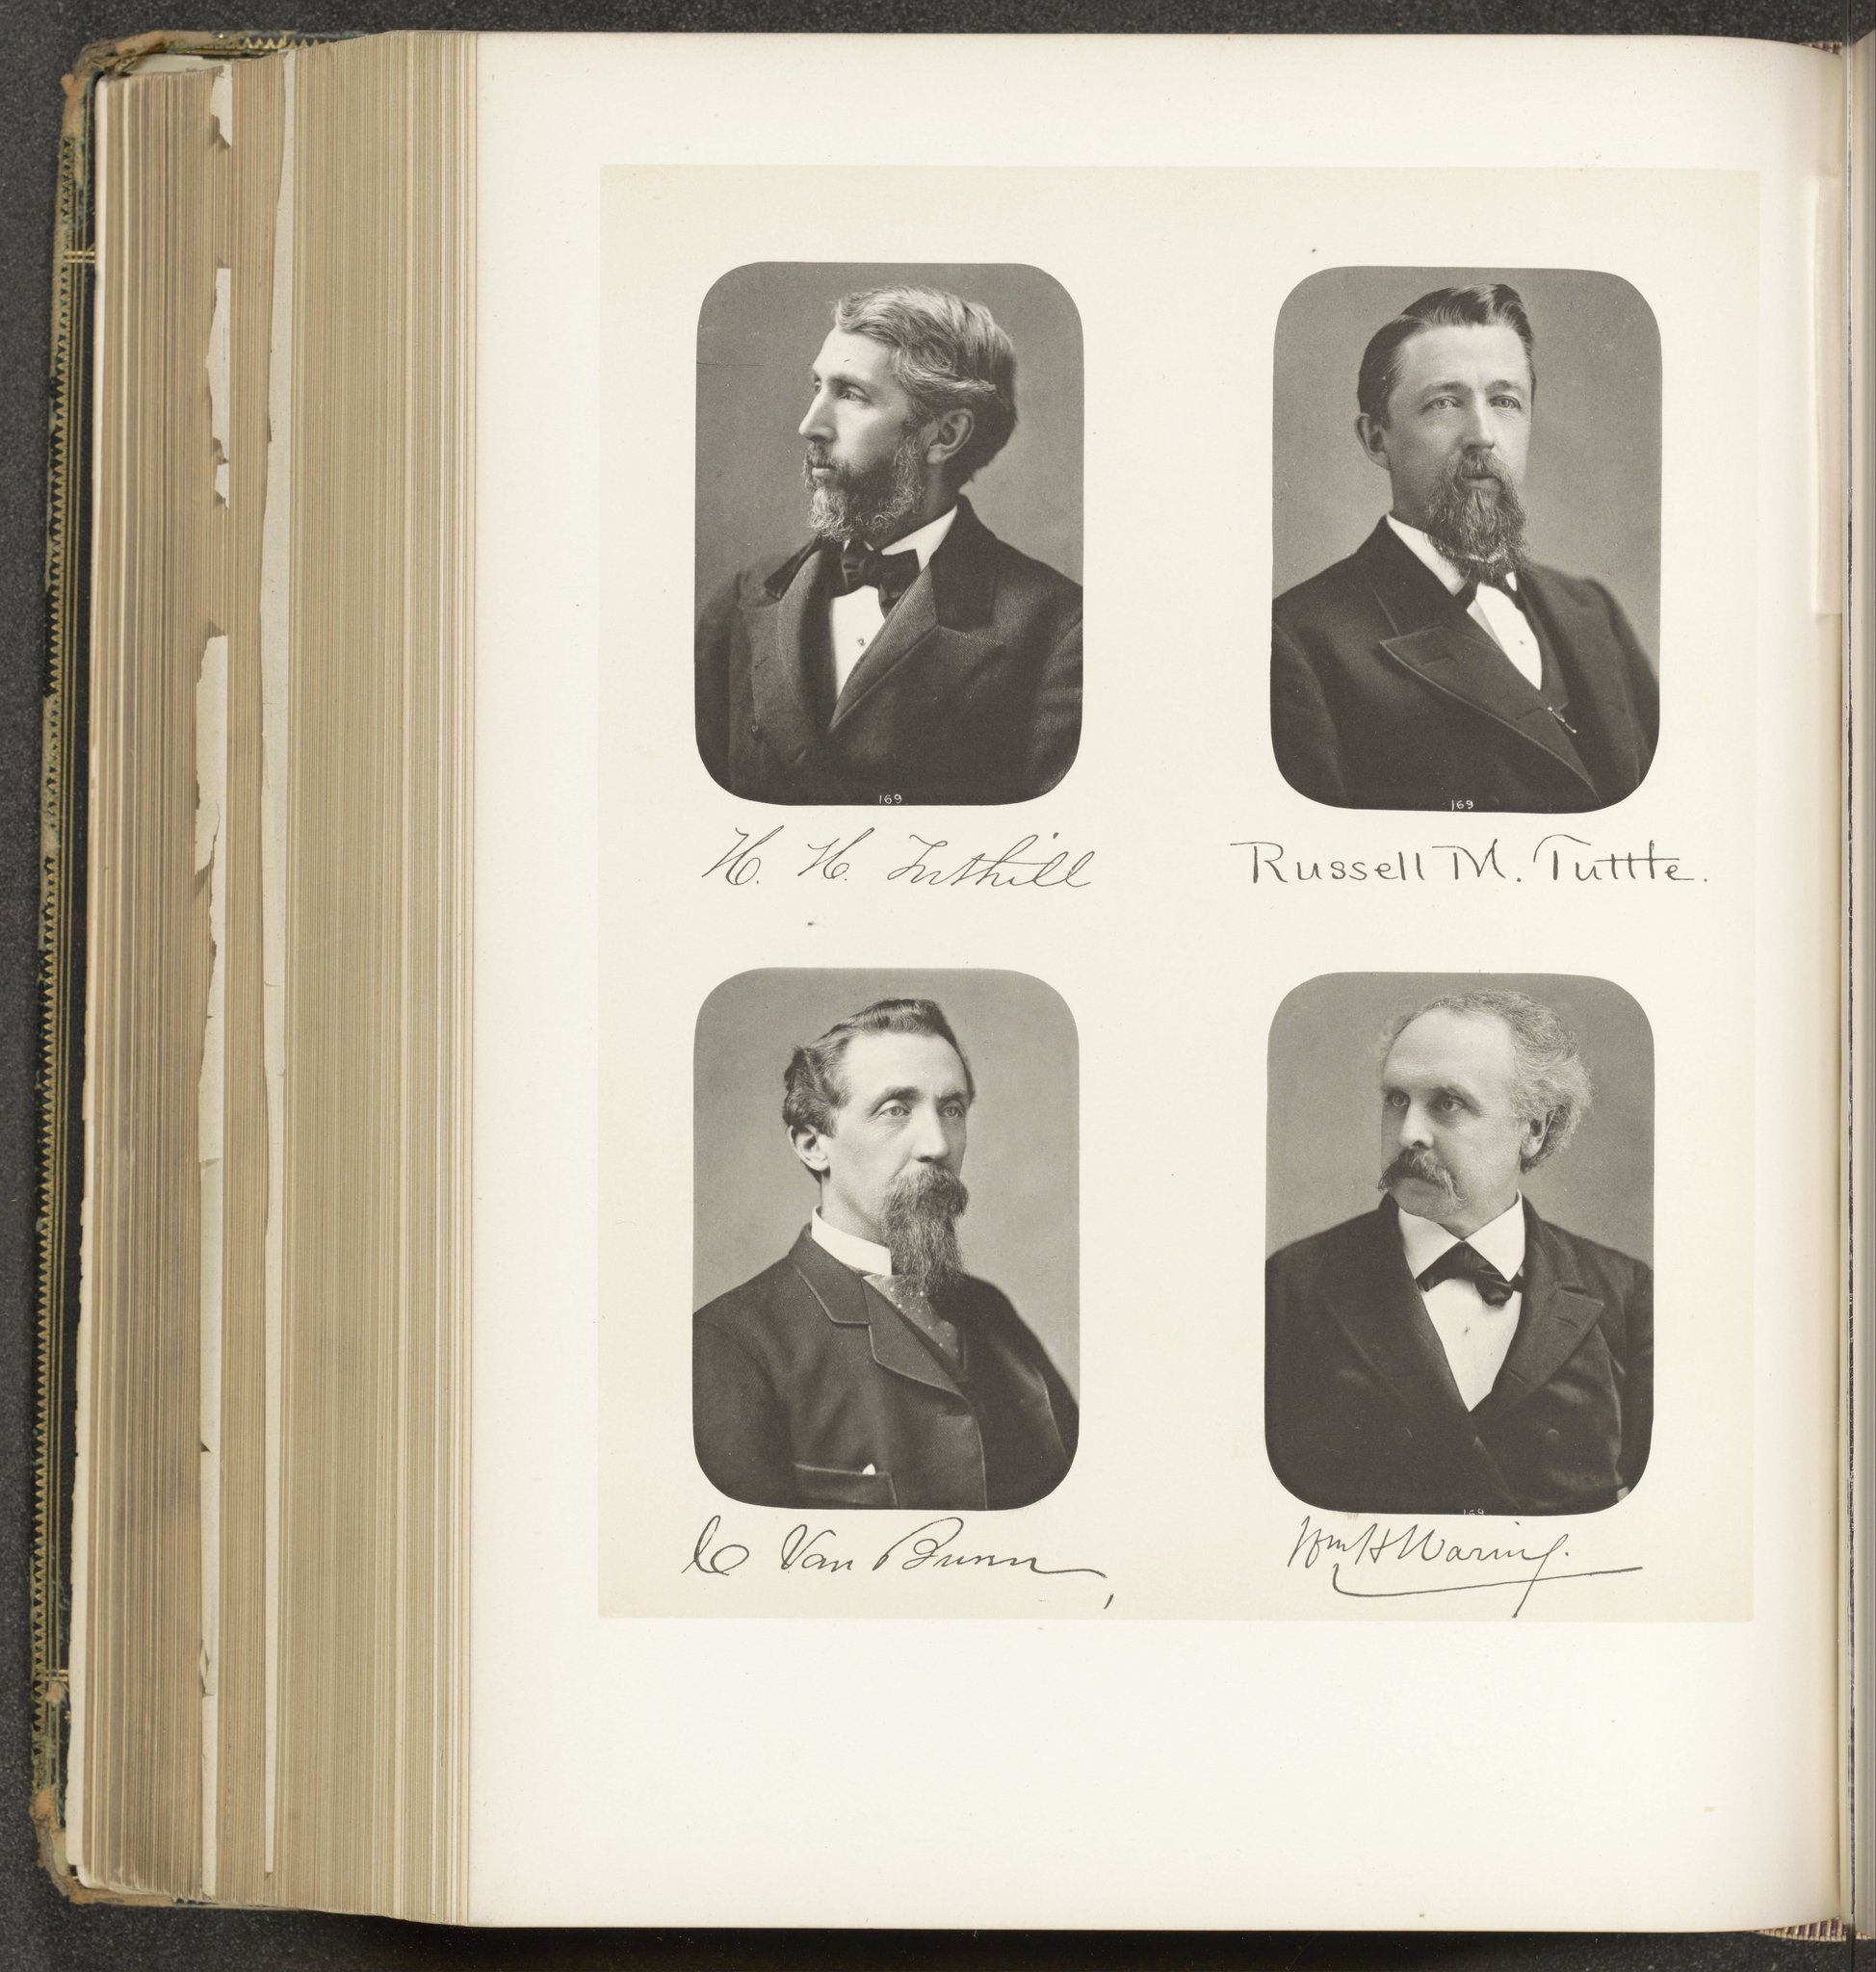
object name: page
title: Portretten van vier leden van het Lagerhuis van de staat New York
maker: Anonymous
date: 1872-1882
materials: paper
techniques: photograph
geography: united states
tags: historical persons (portraits and scenes from the life) (+ head (and shoulders) (portrait))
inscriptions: number: ‘170’, annotation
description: Linksboven Samuel R. Welles, rechtsboven David A. Wells, linksonder Arthur D. Williams, rechtsonder J. Coe Young.